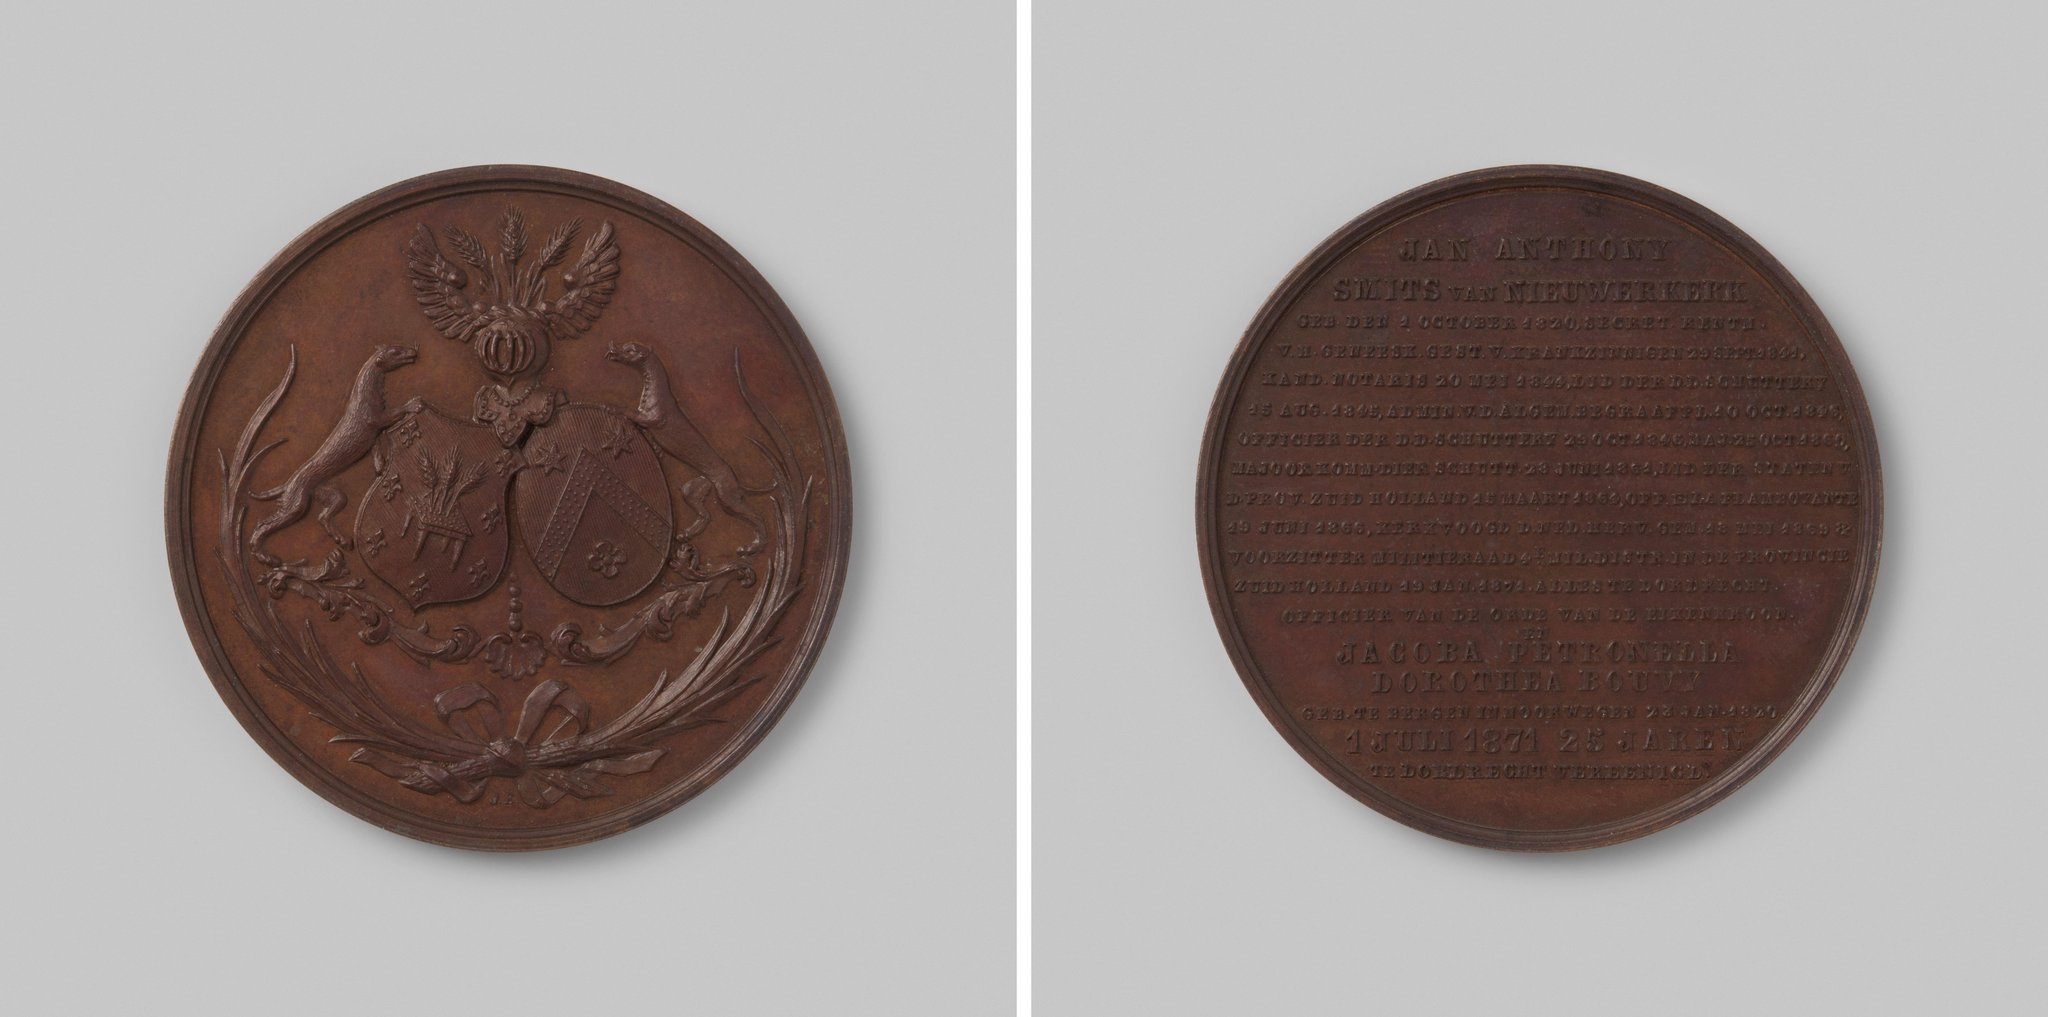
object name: family medal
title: Vijfentwintigjarig huwelijk van Jan Anthony Smits van Nieuwerkerk, lid van de Staten van Zuid-Holland en Jacoba Petronella Dorothea Bouvy te Dordrecht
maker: jacob samuel cohen elion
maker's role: draughtsman, painter, print maker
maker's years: 1840-1893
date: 1871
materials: bronze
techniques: striking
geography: amsterdam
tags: johan anthony smits van nieuwerkerk, dordrecht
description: Bronzen penning. Voorzijde: twee wapenschilden onder een gevleugelde helm, geflankeerd door twee dieren boven twee samengebonden palmtakken. Keerzijde: opschrift.